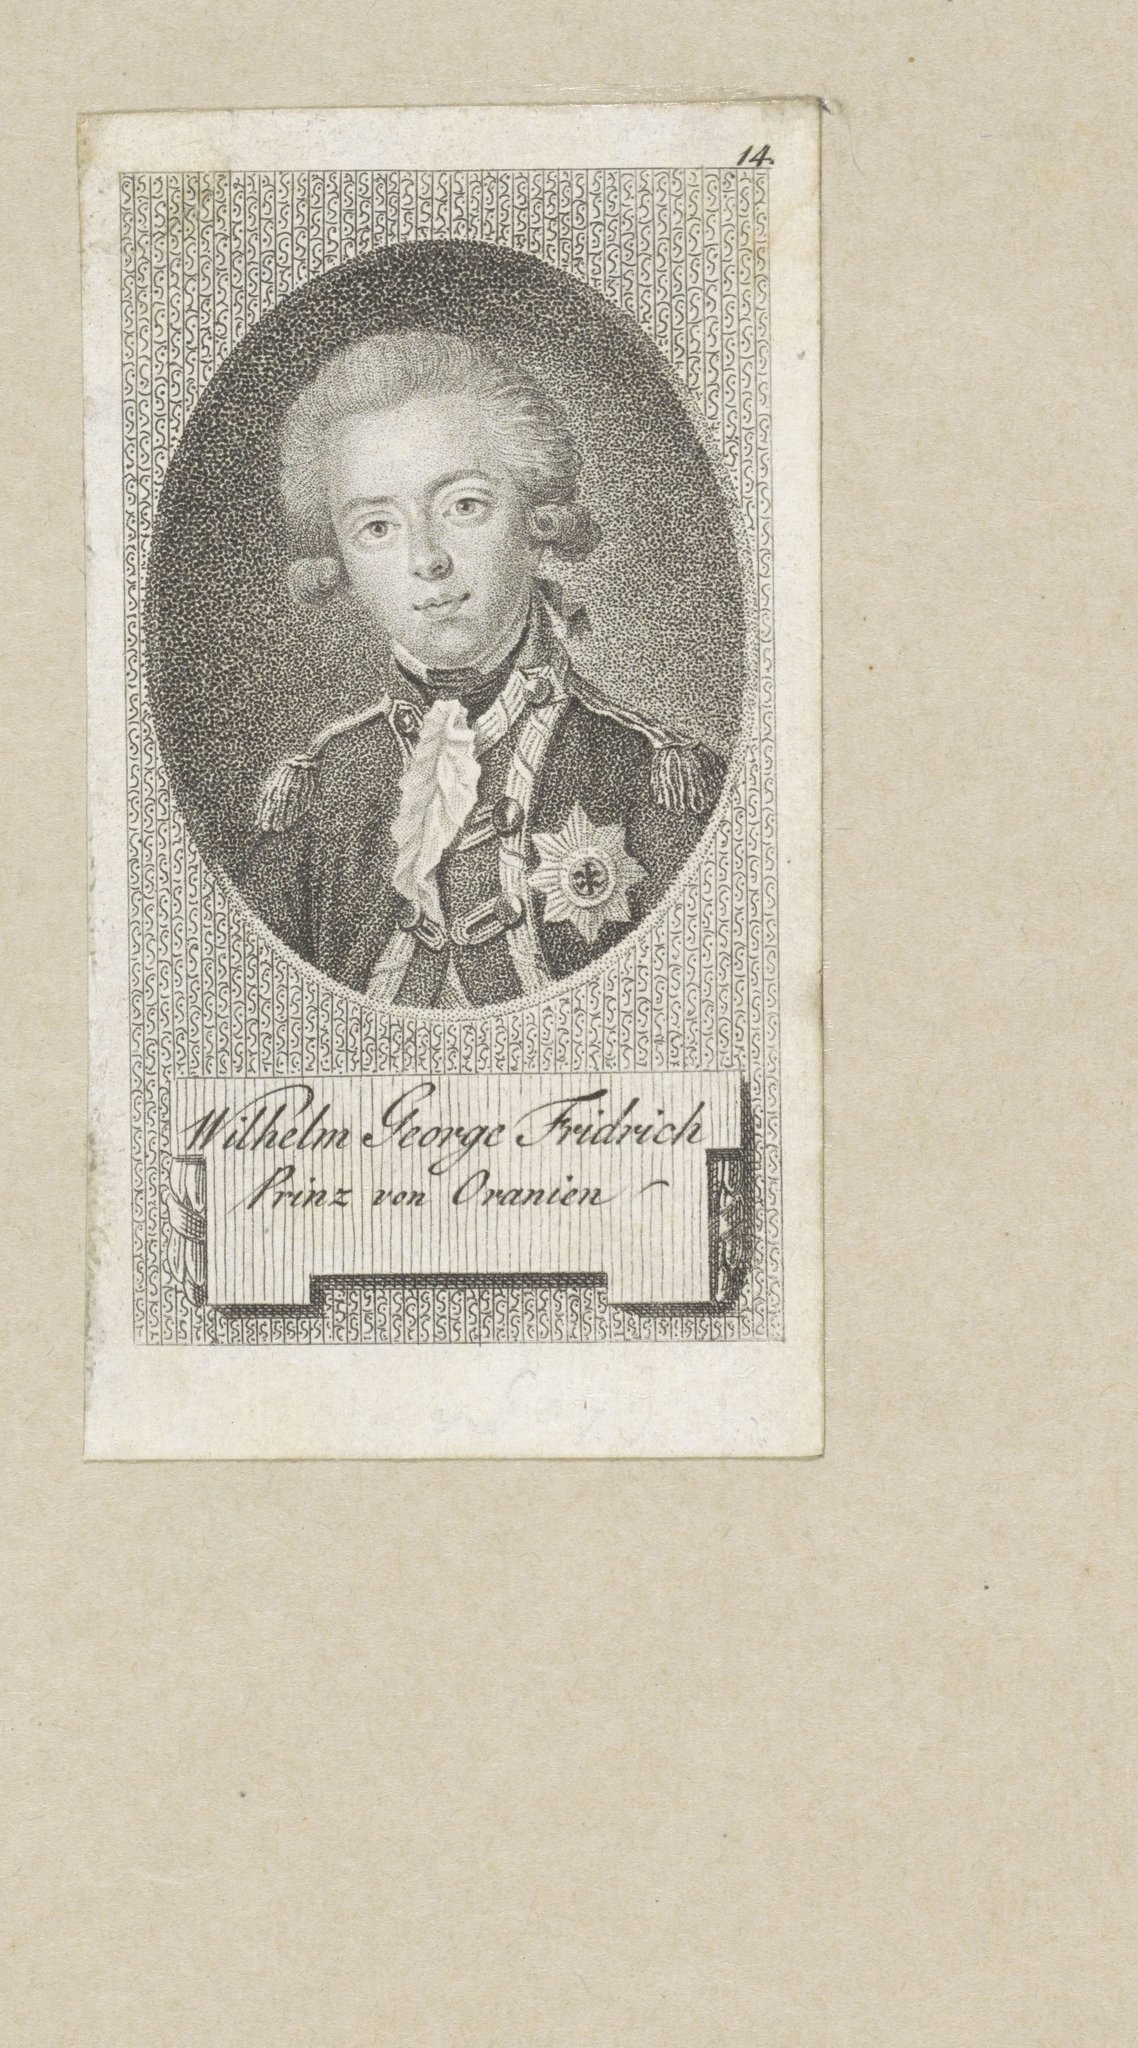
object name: print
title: Portret van Frederik, prins van Oranje-Nassau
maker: Anonymous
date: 1790-1849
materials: paper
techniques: engraving, etching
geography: low countries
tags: the hague, willem george frederik (prins van oranje-nassau), knighthood order (with name) - insignia of a knighthood order, e.g.: badge, chain (with name of order)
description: De hier vermelde titel verwijst naar de hoogst verkregen titel van de geportretteerde, niet per se naar de titel die de geportretteerde op deze voorstelling draagt.